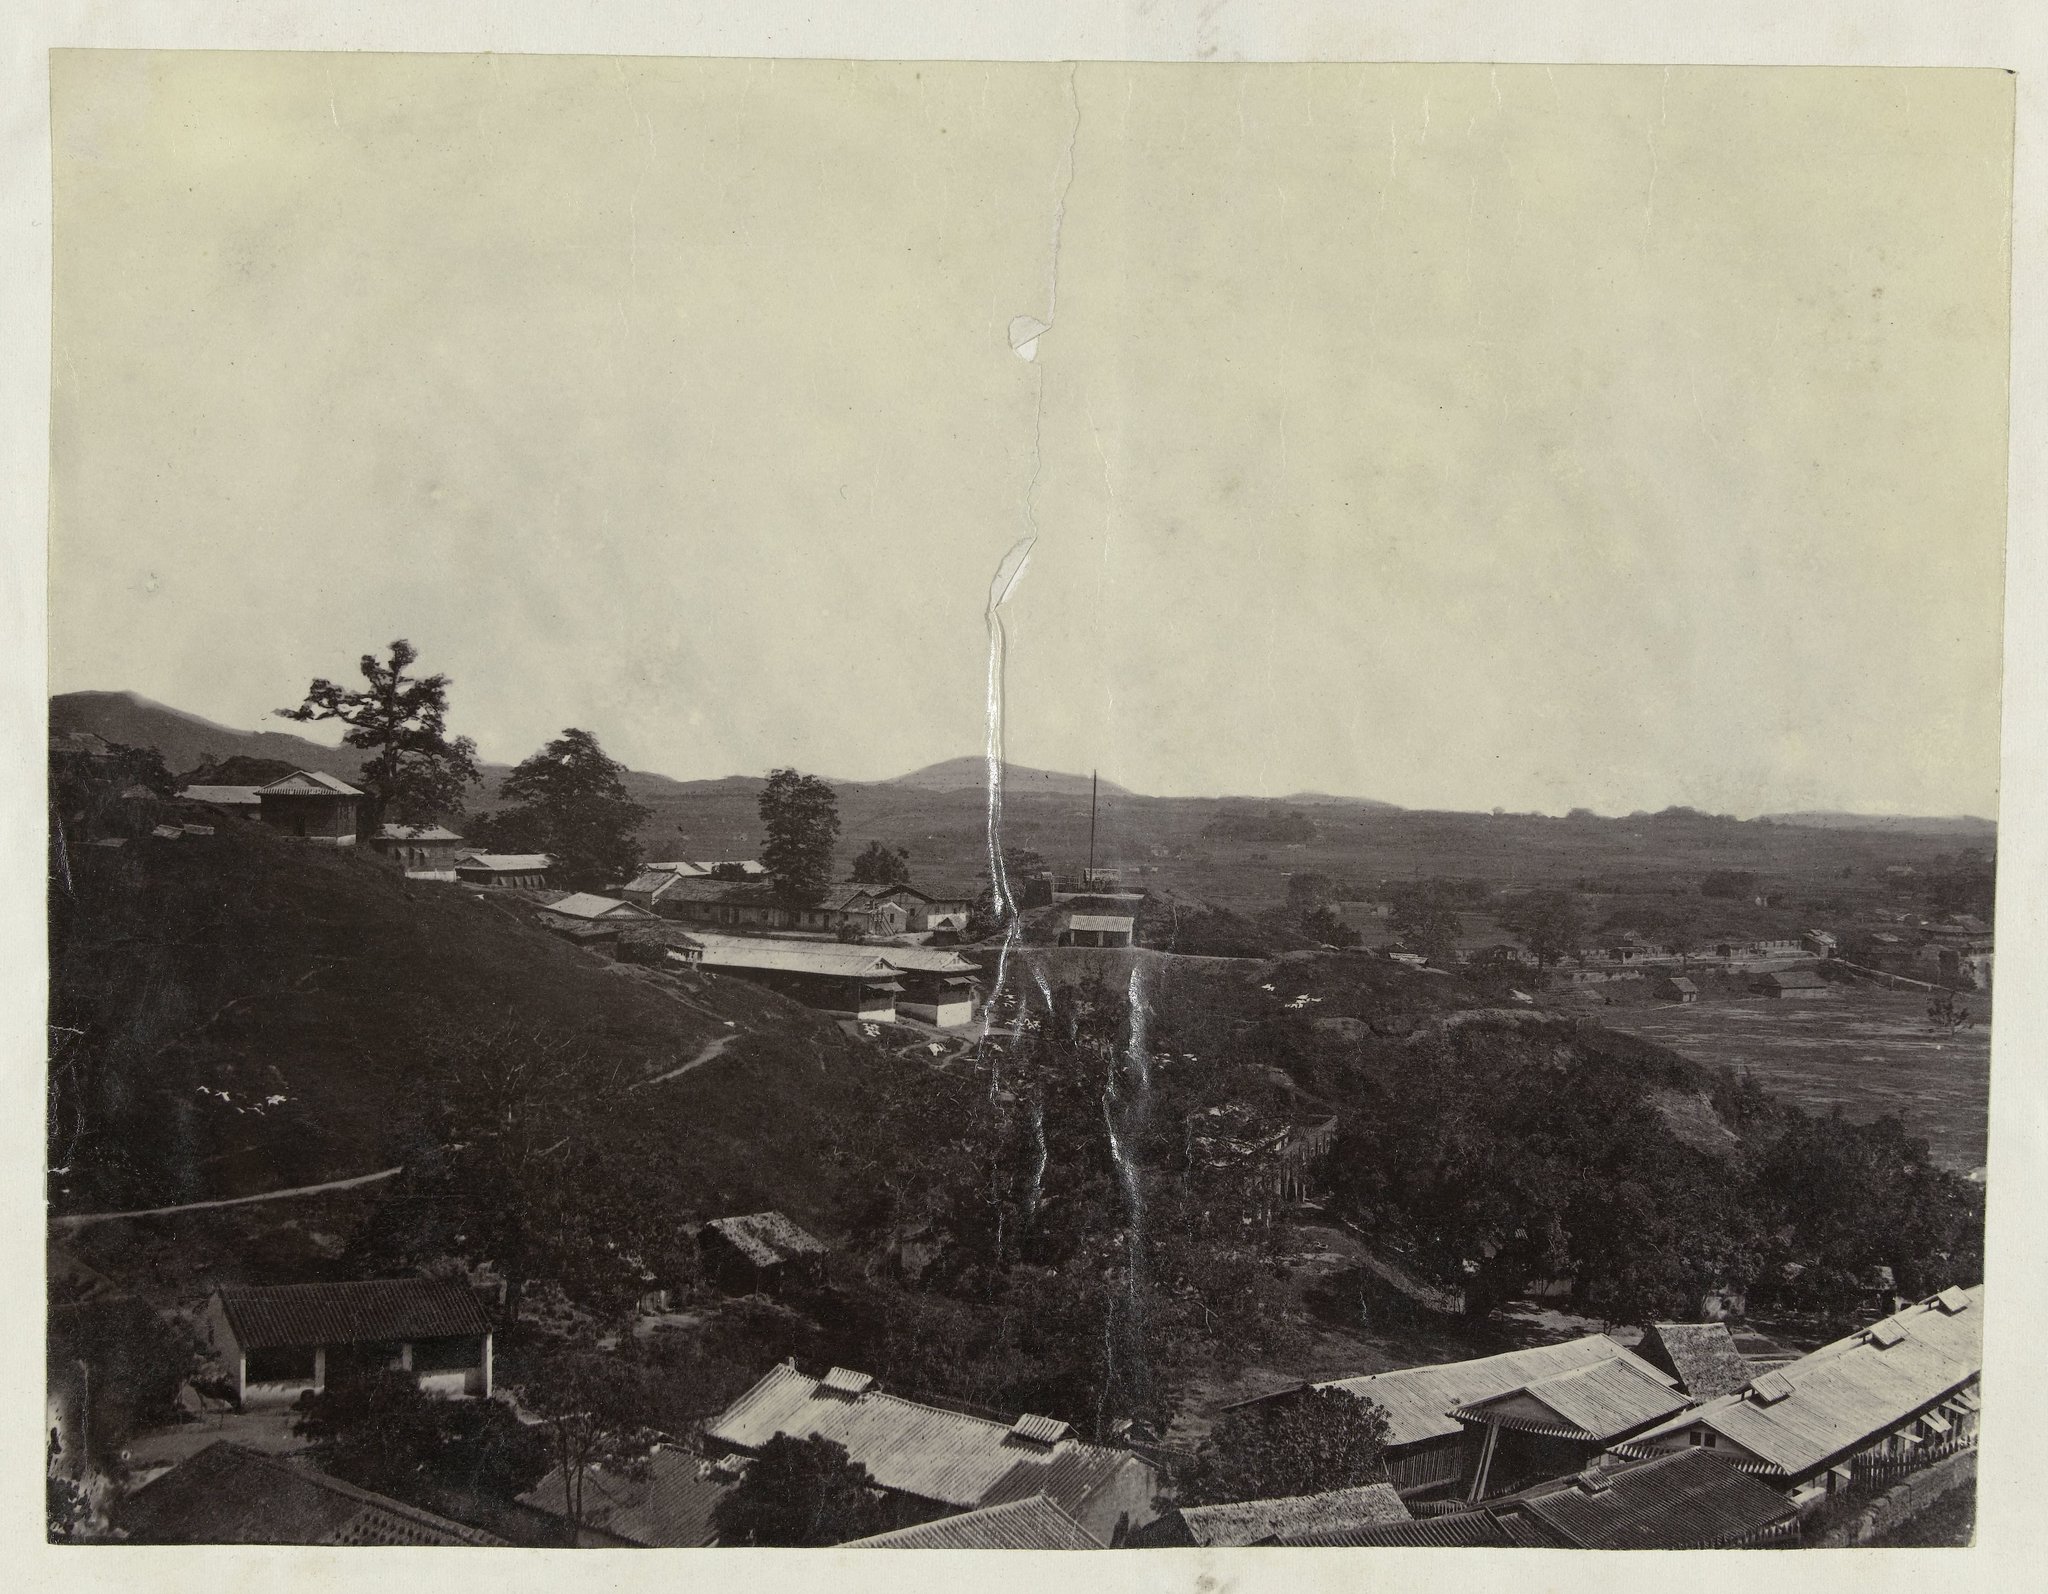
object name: album leaf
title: Gezicht op huizen en heuvels, China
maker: Anonymous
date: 1879-1890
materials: paper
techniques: albumen print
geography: china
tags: (high) hill, china